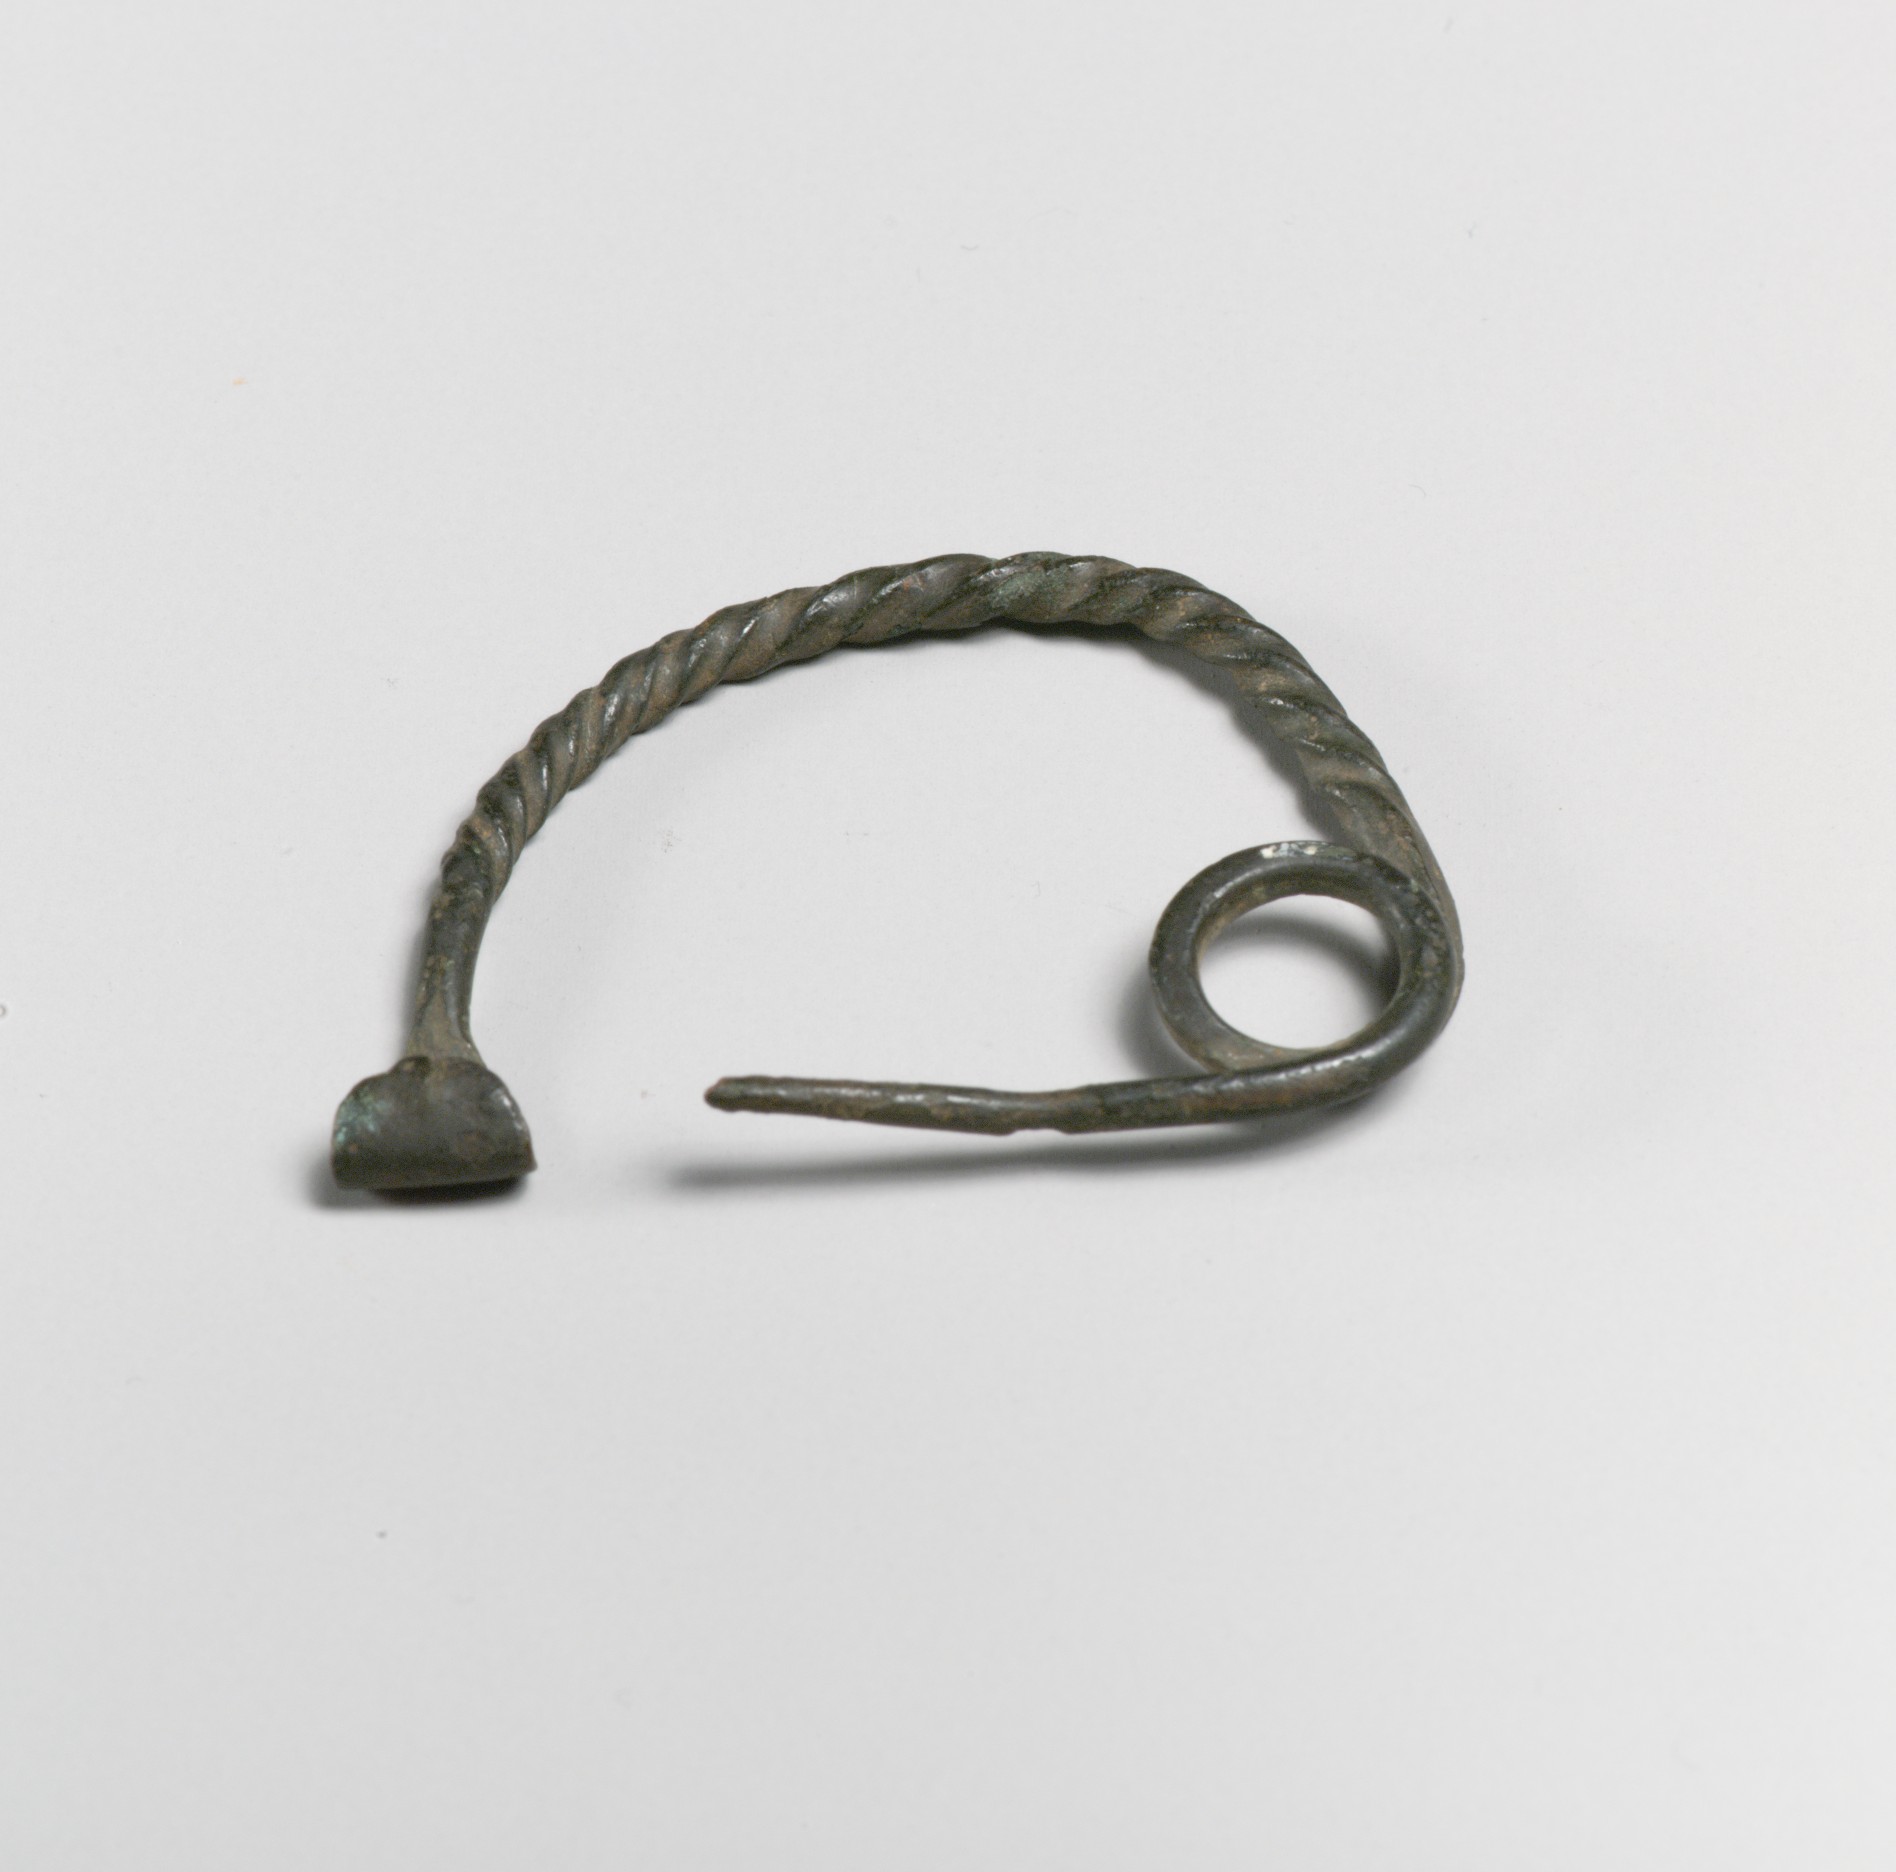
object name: fibula, semicircular type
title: Fibula, semi-circular type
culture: italic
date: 1200-901 BCE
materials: bronze